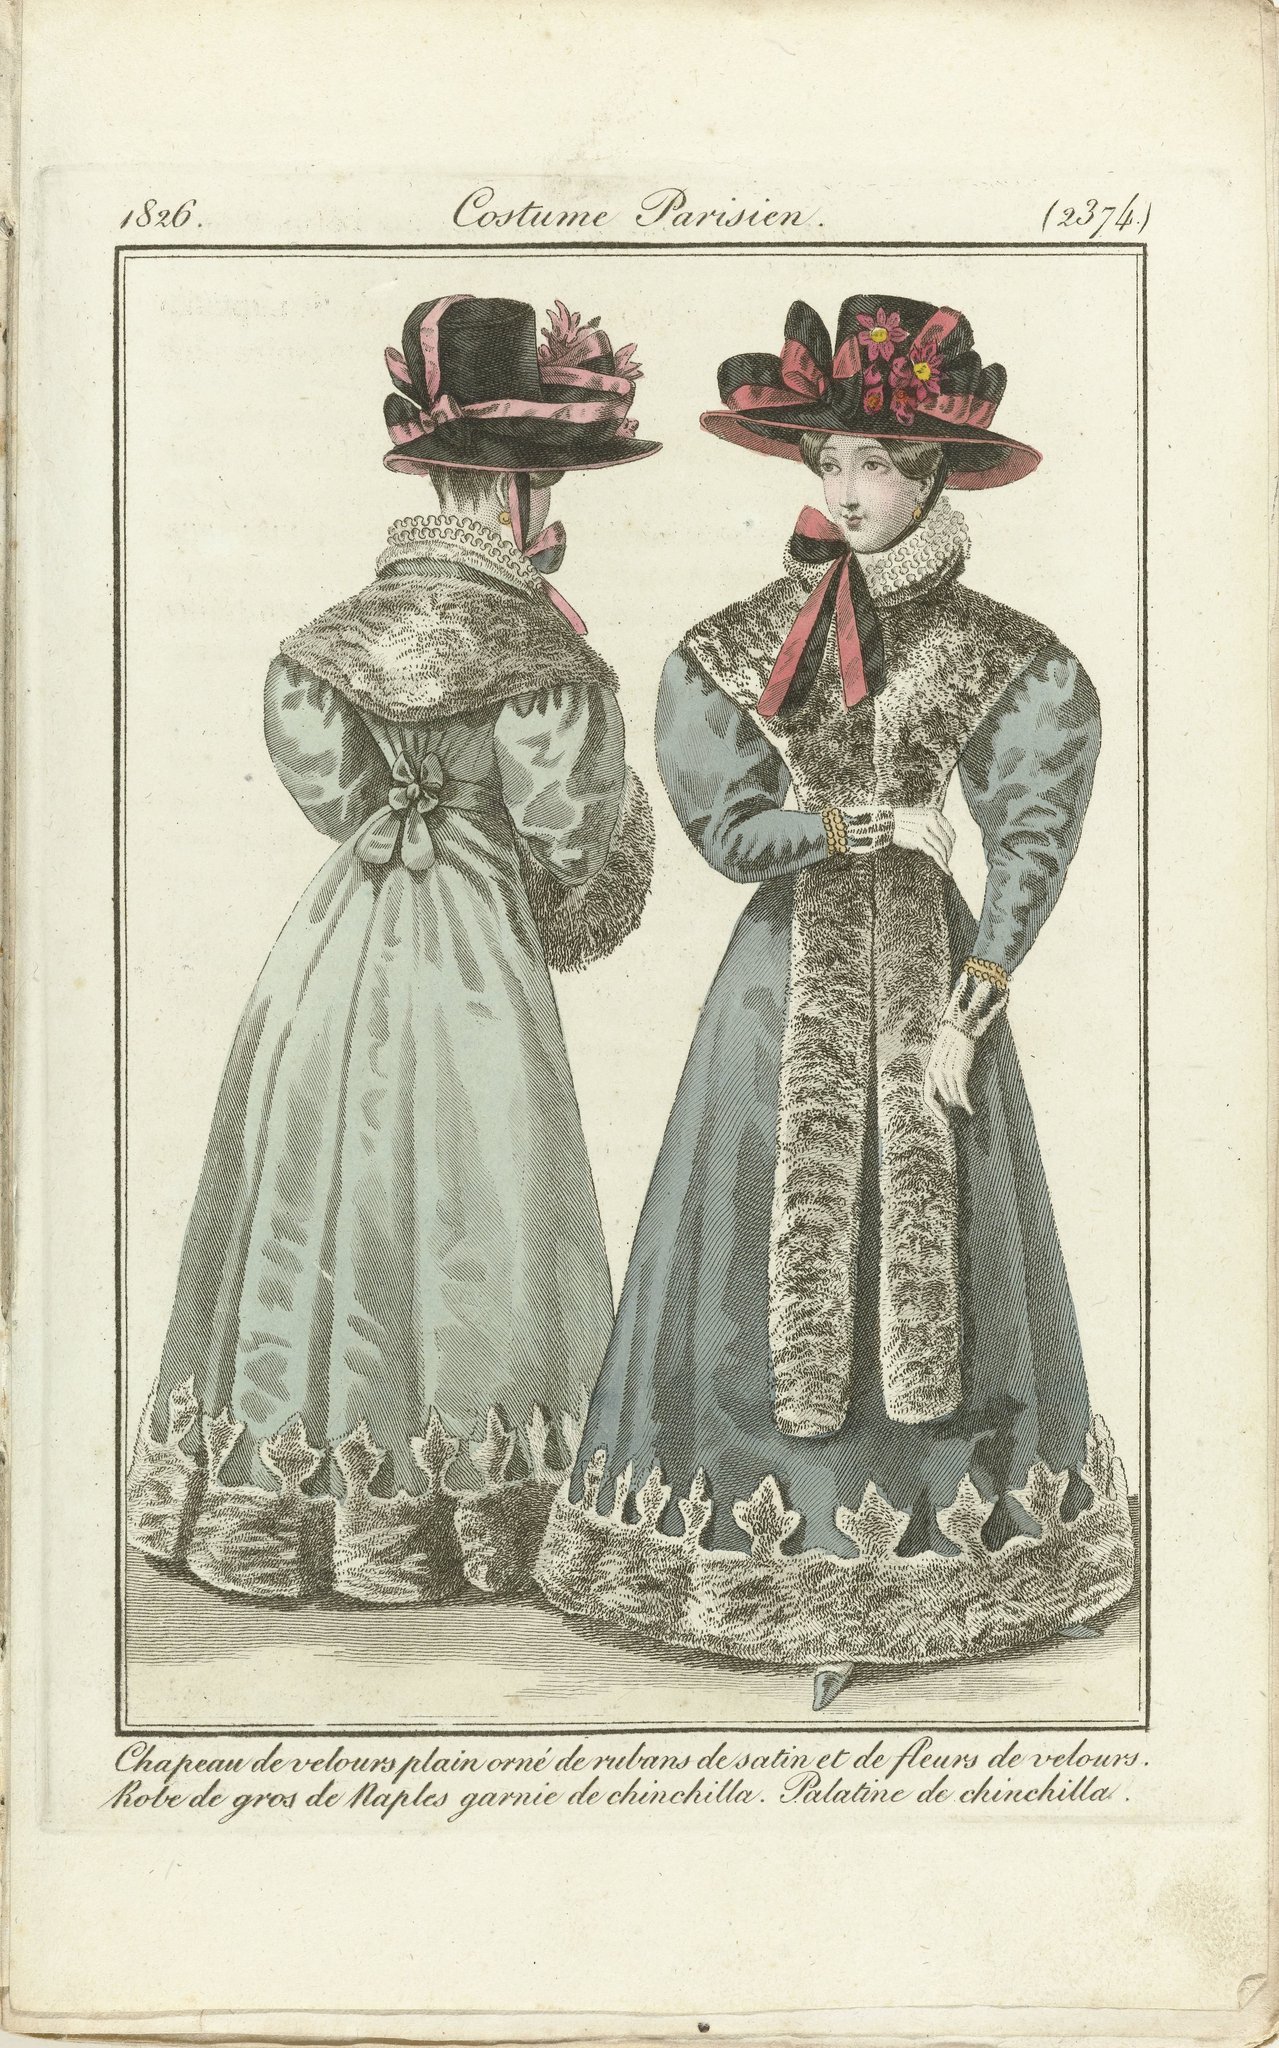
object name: fashion print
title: Journal des dames et des modes, Costume Parisien 1826 (2374)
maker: Anonymous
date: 1826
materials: paper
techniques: etching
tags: fashion plates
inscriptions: date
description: Chapeau de velours plain orné de rubans de satin et de fleurs de velours. Robe de gros de naples garnie de chinchilla. Palatine de chinchilla.